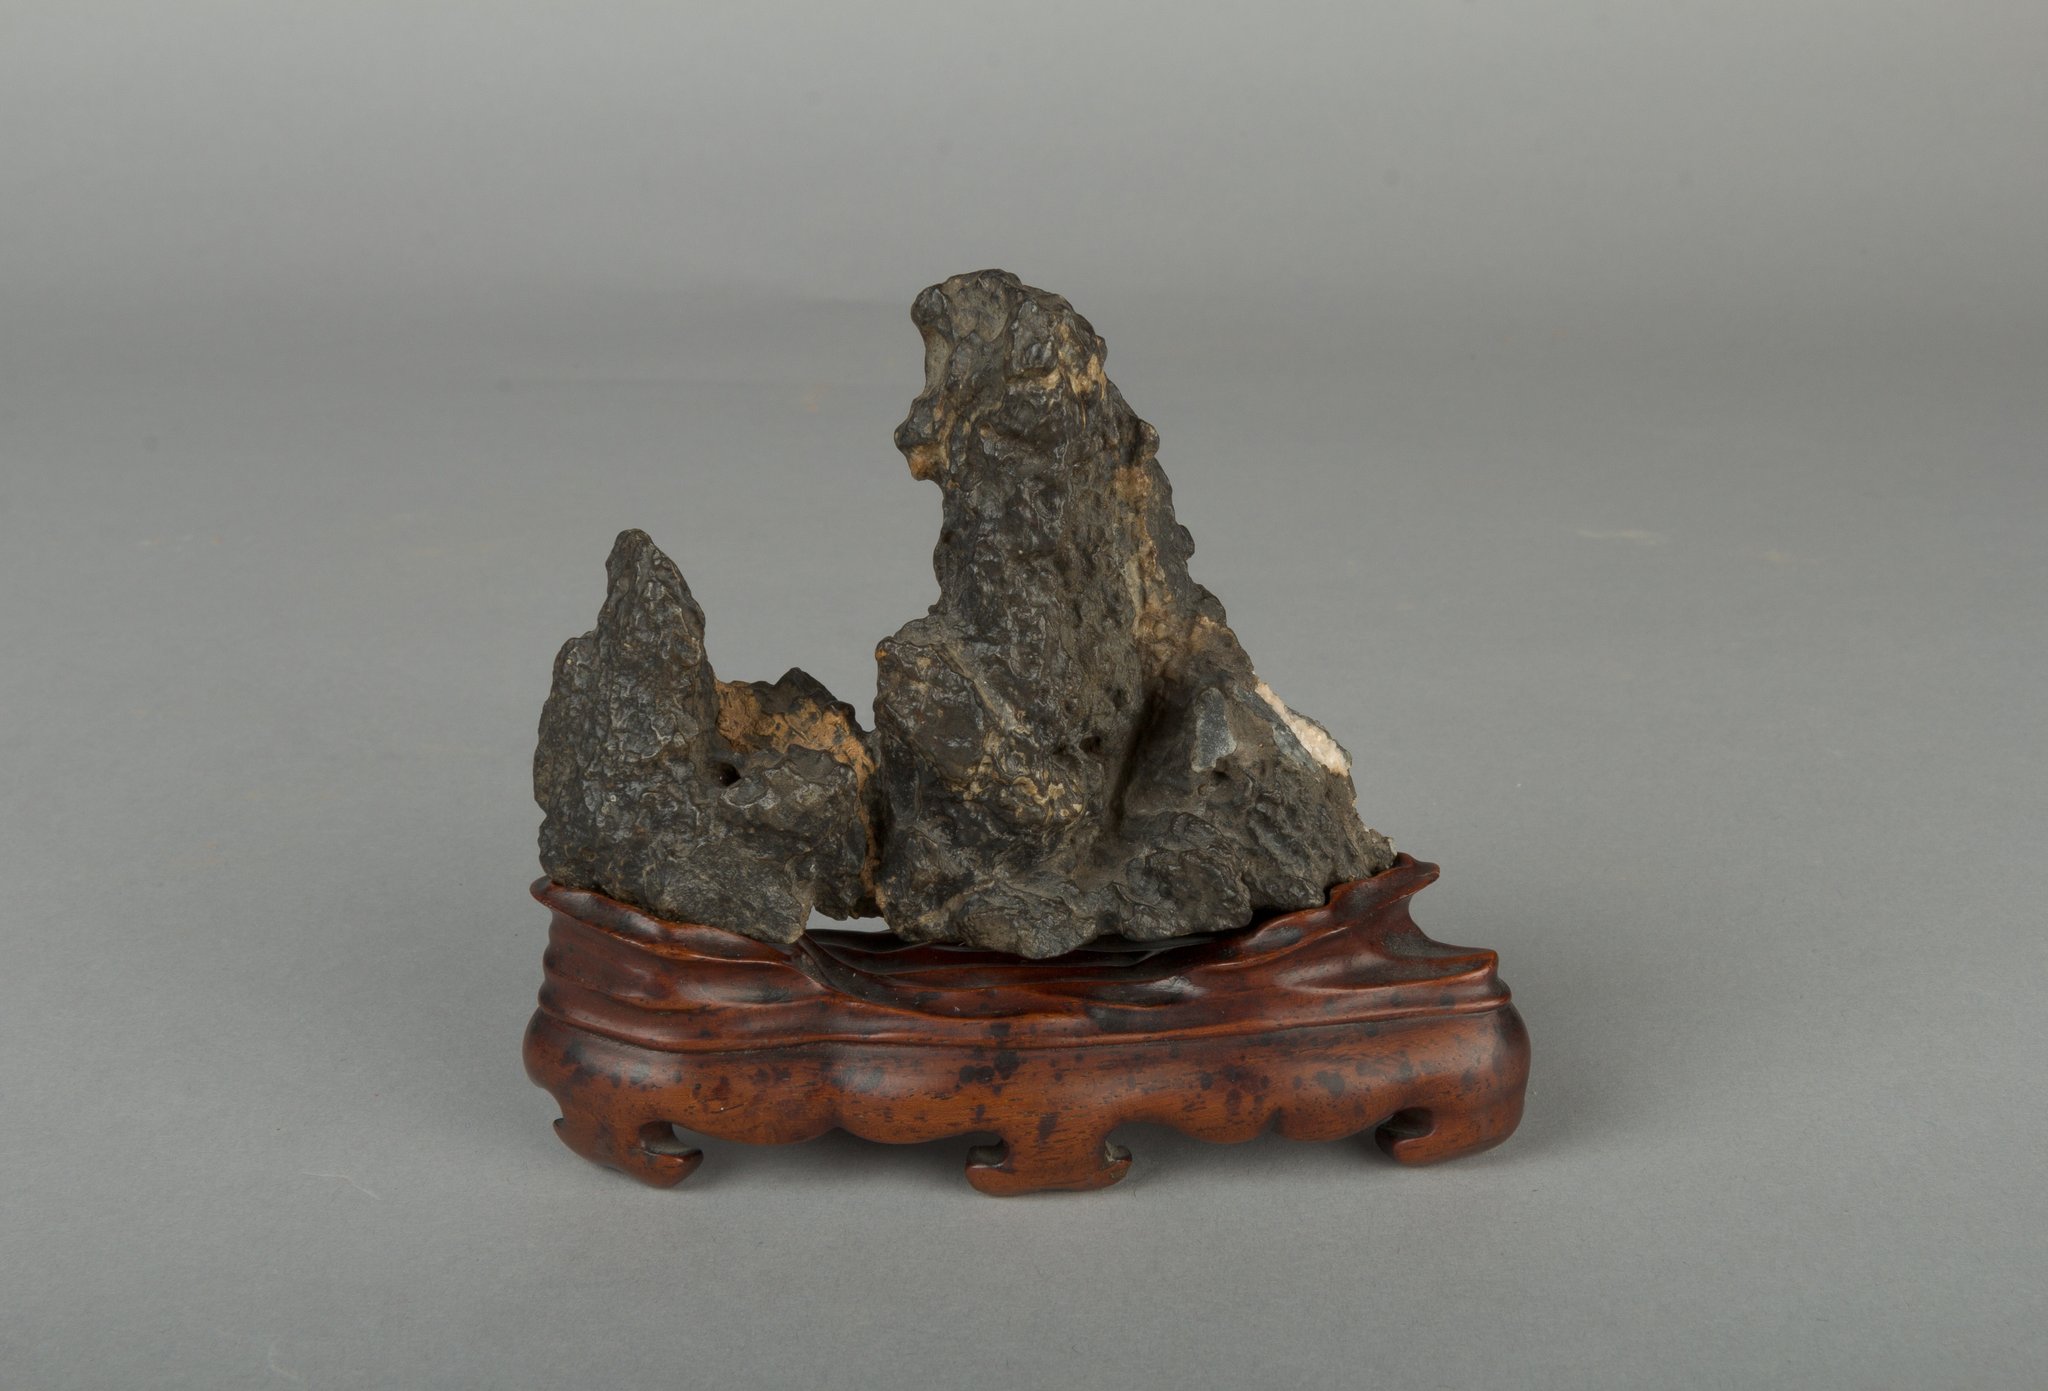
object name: scholar's rock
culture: chinese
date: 1644-1911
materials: limestone, wood